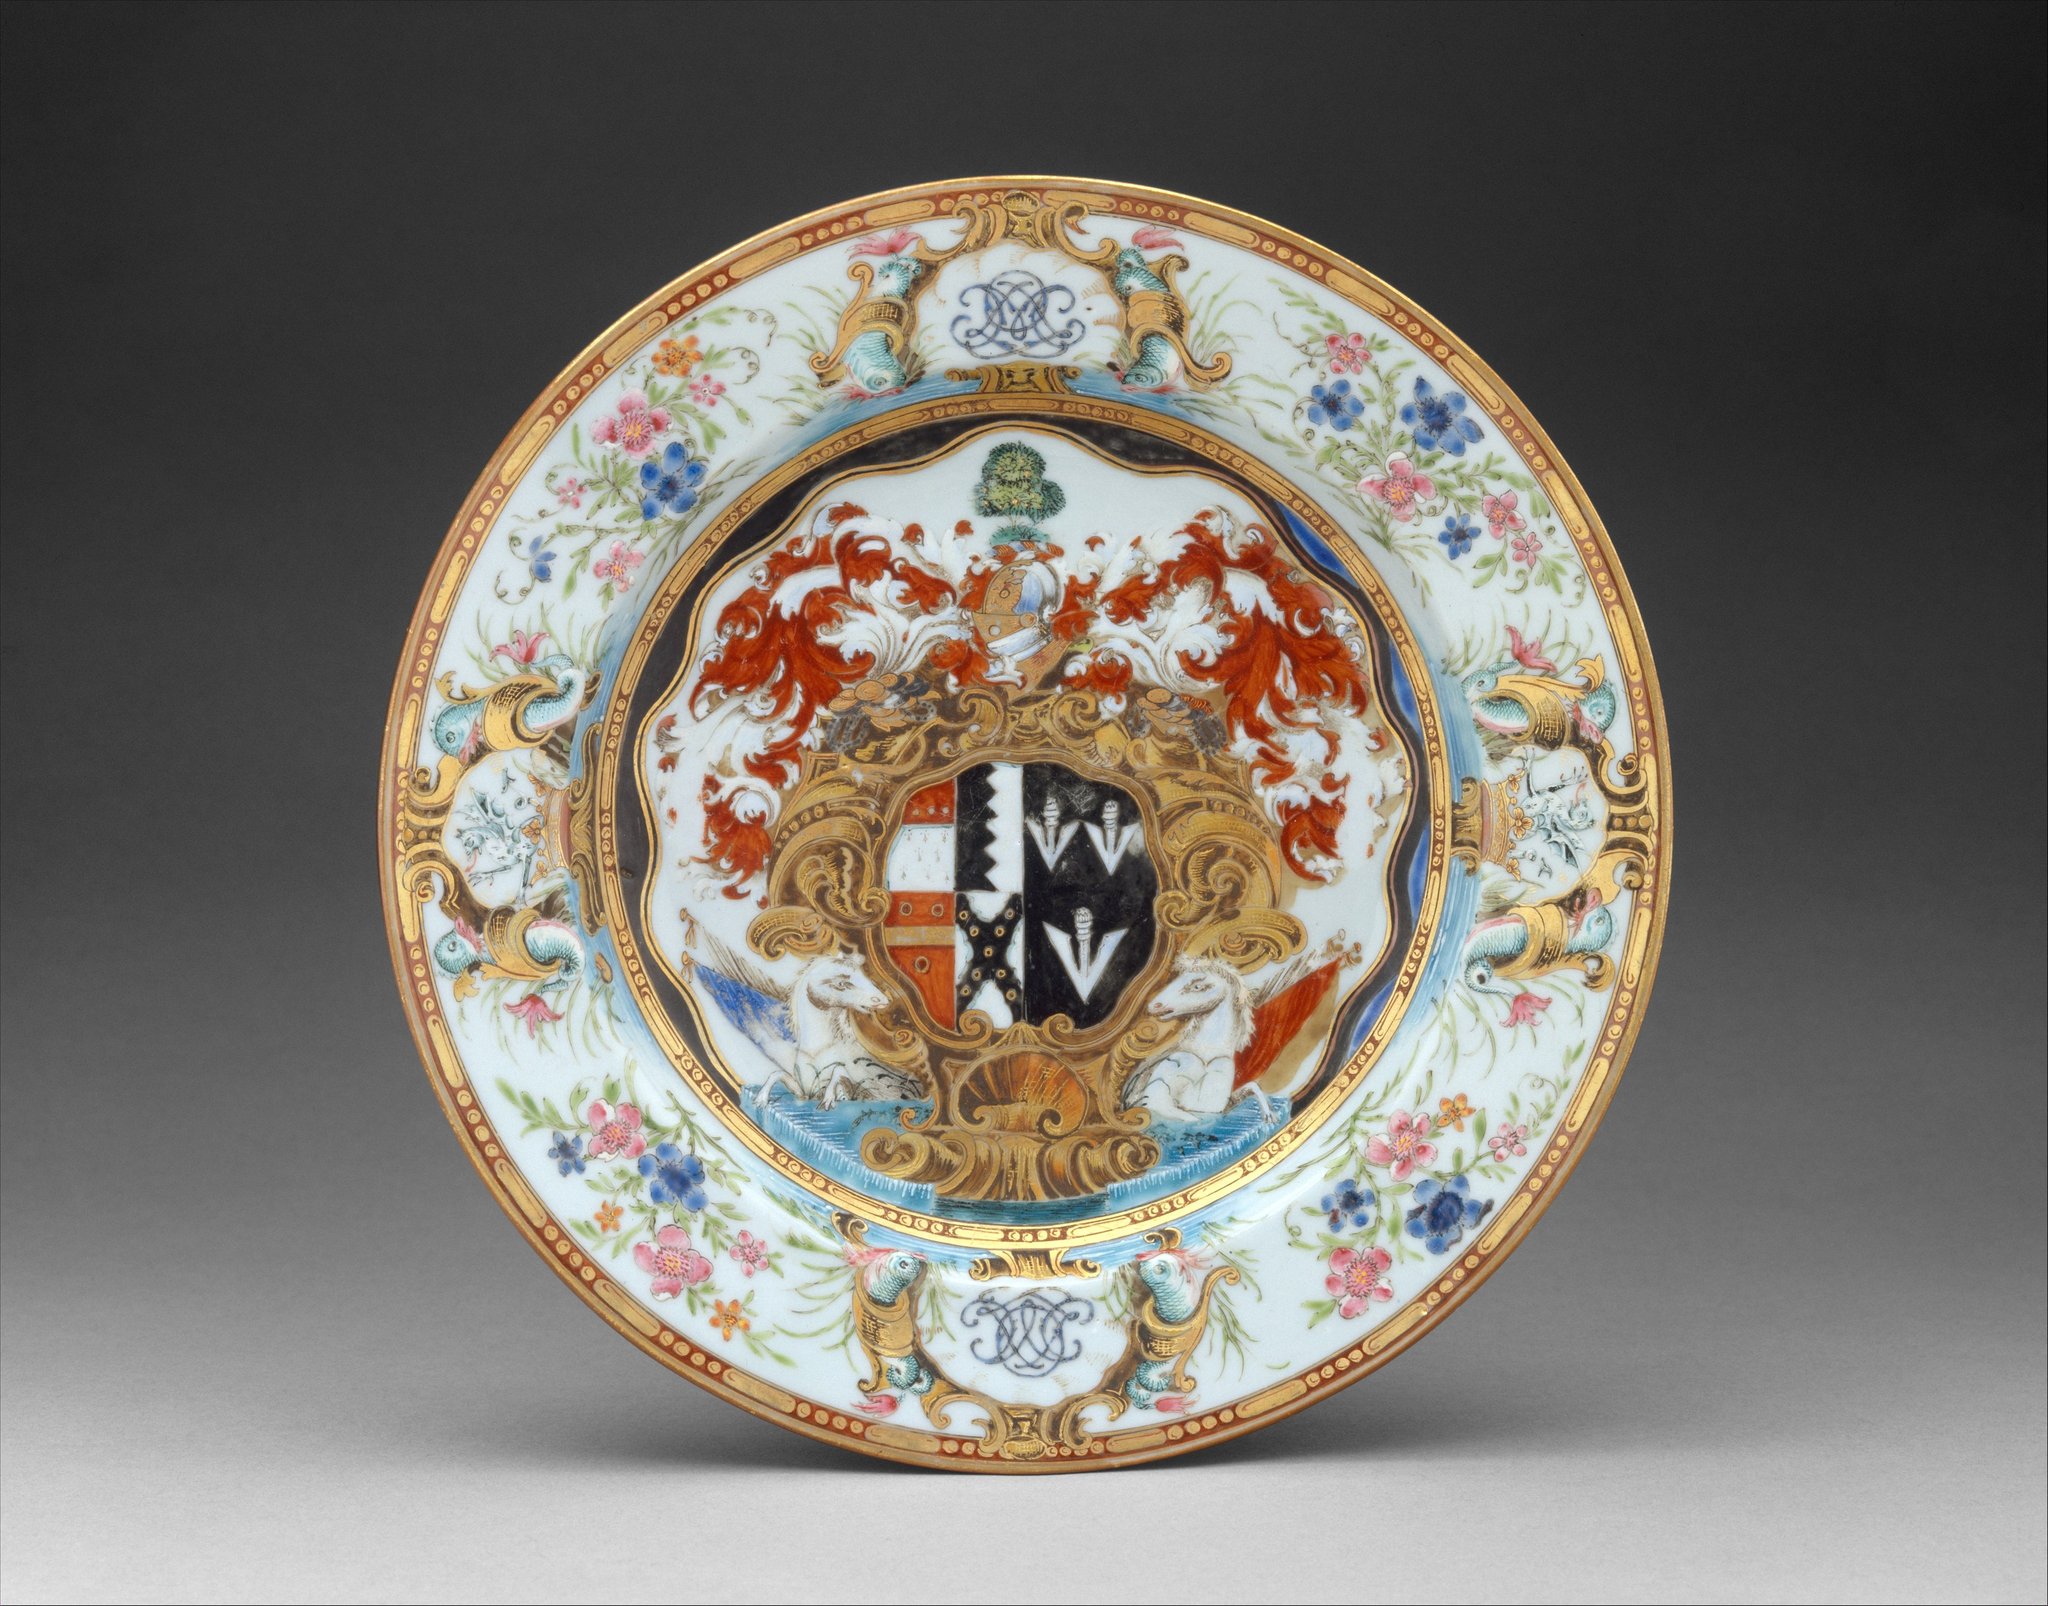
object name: plate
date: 1739-1743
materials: hard paste porcelain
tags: coat of arms